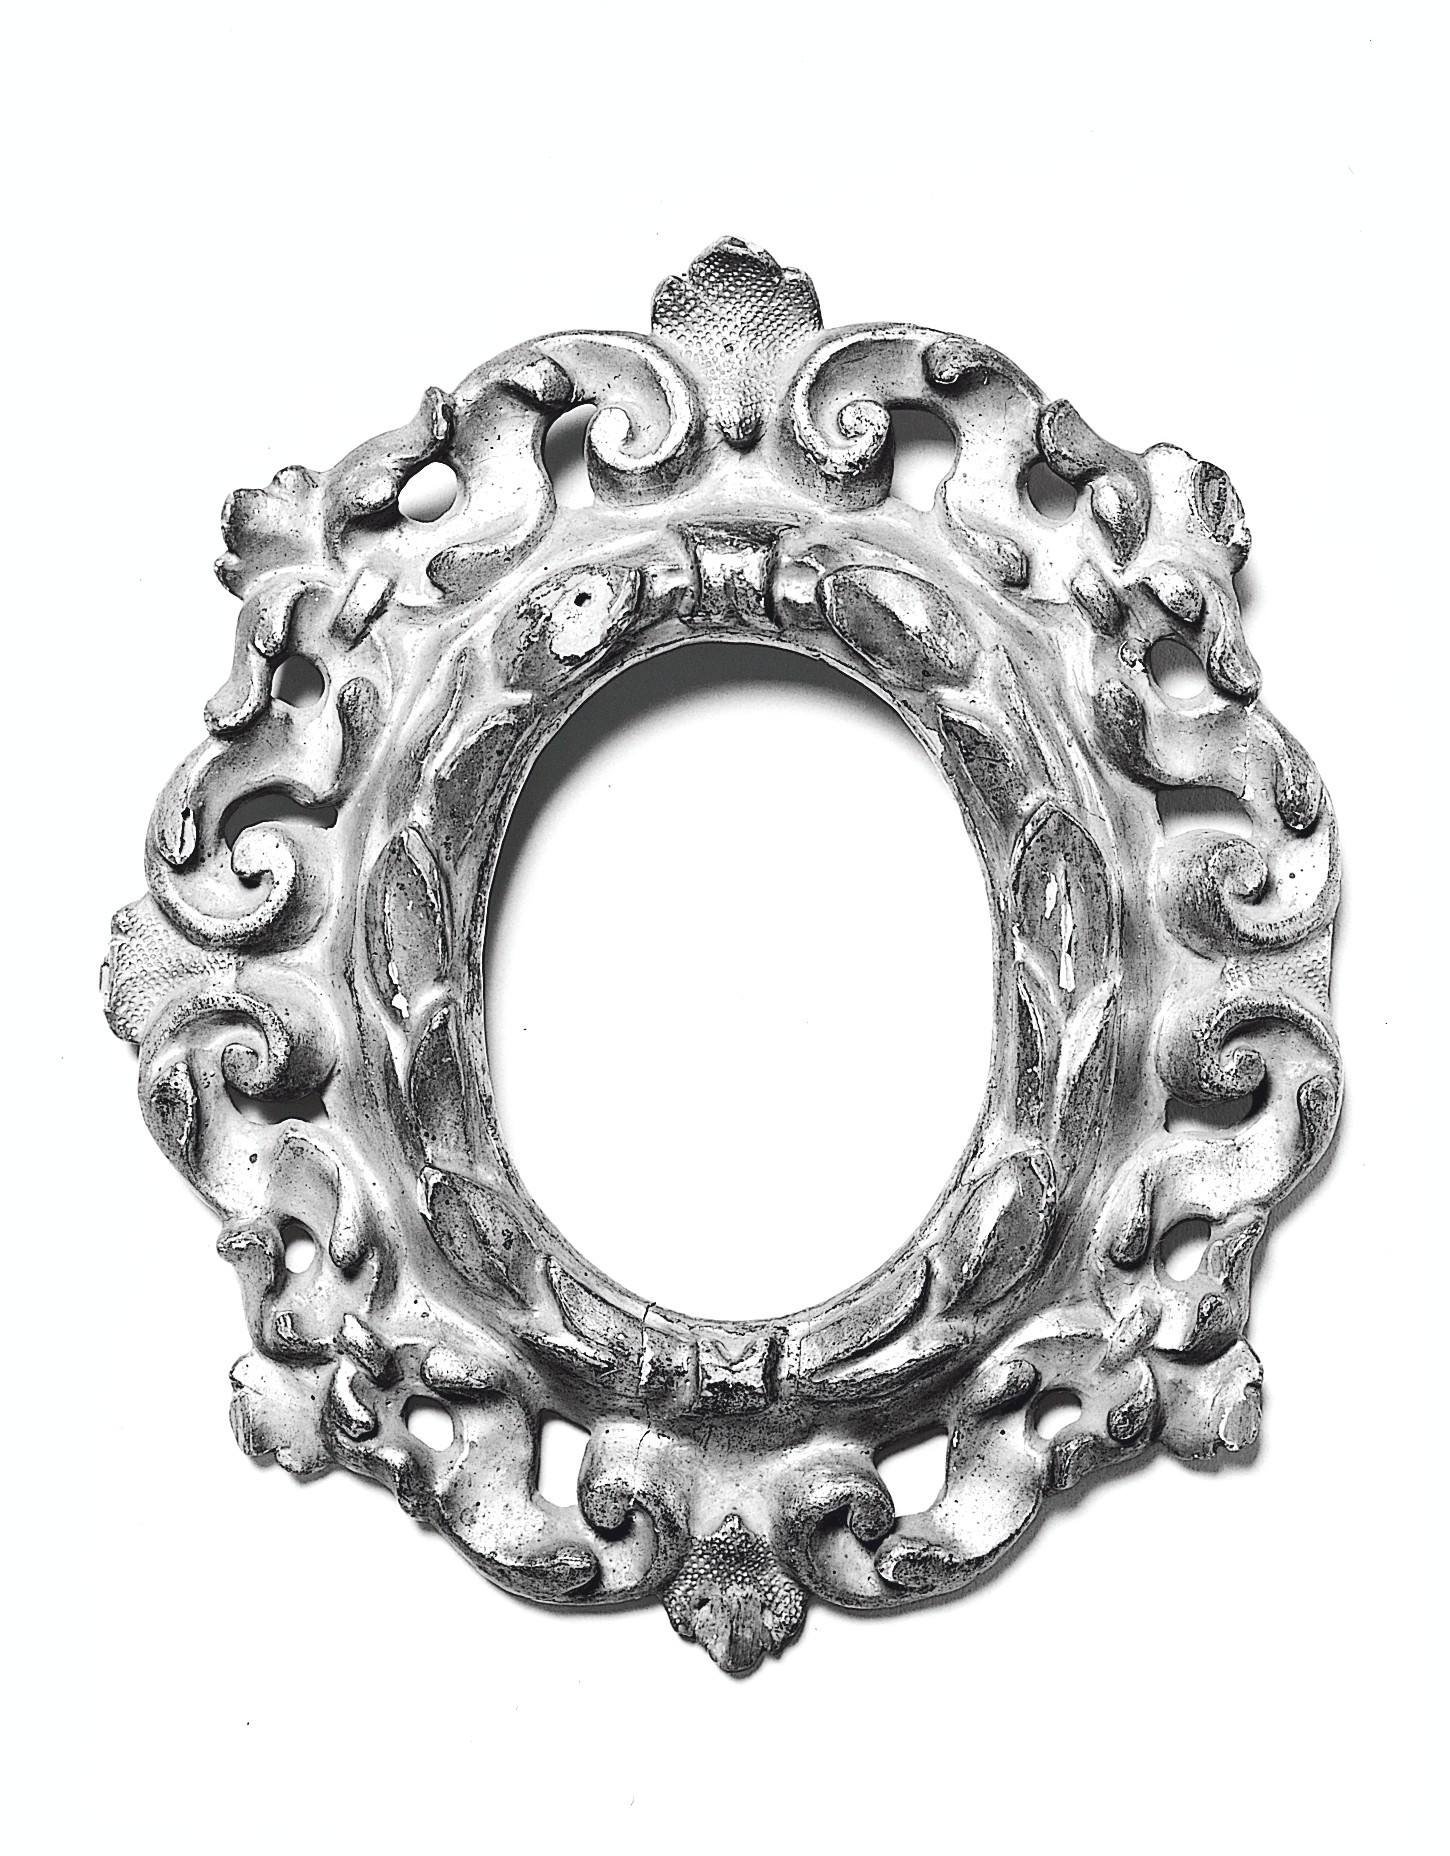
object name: frame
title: Palatina-style oval frame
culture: italian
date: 1667-1700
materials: wood